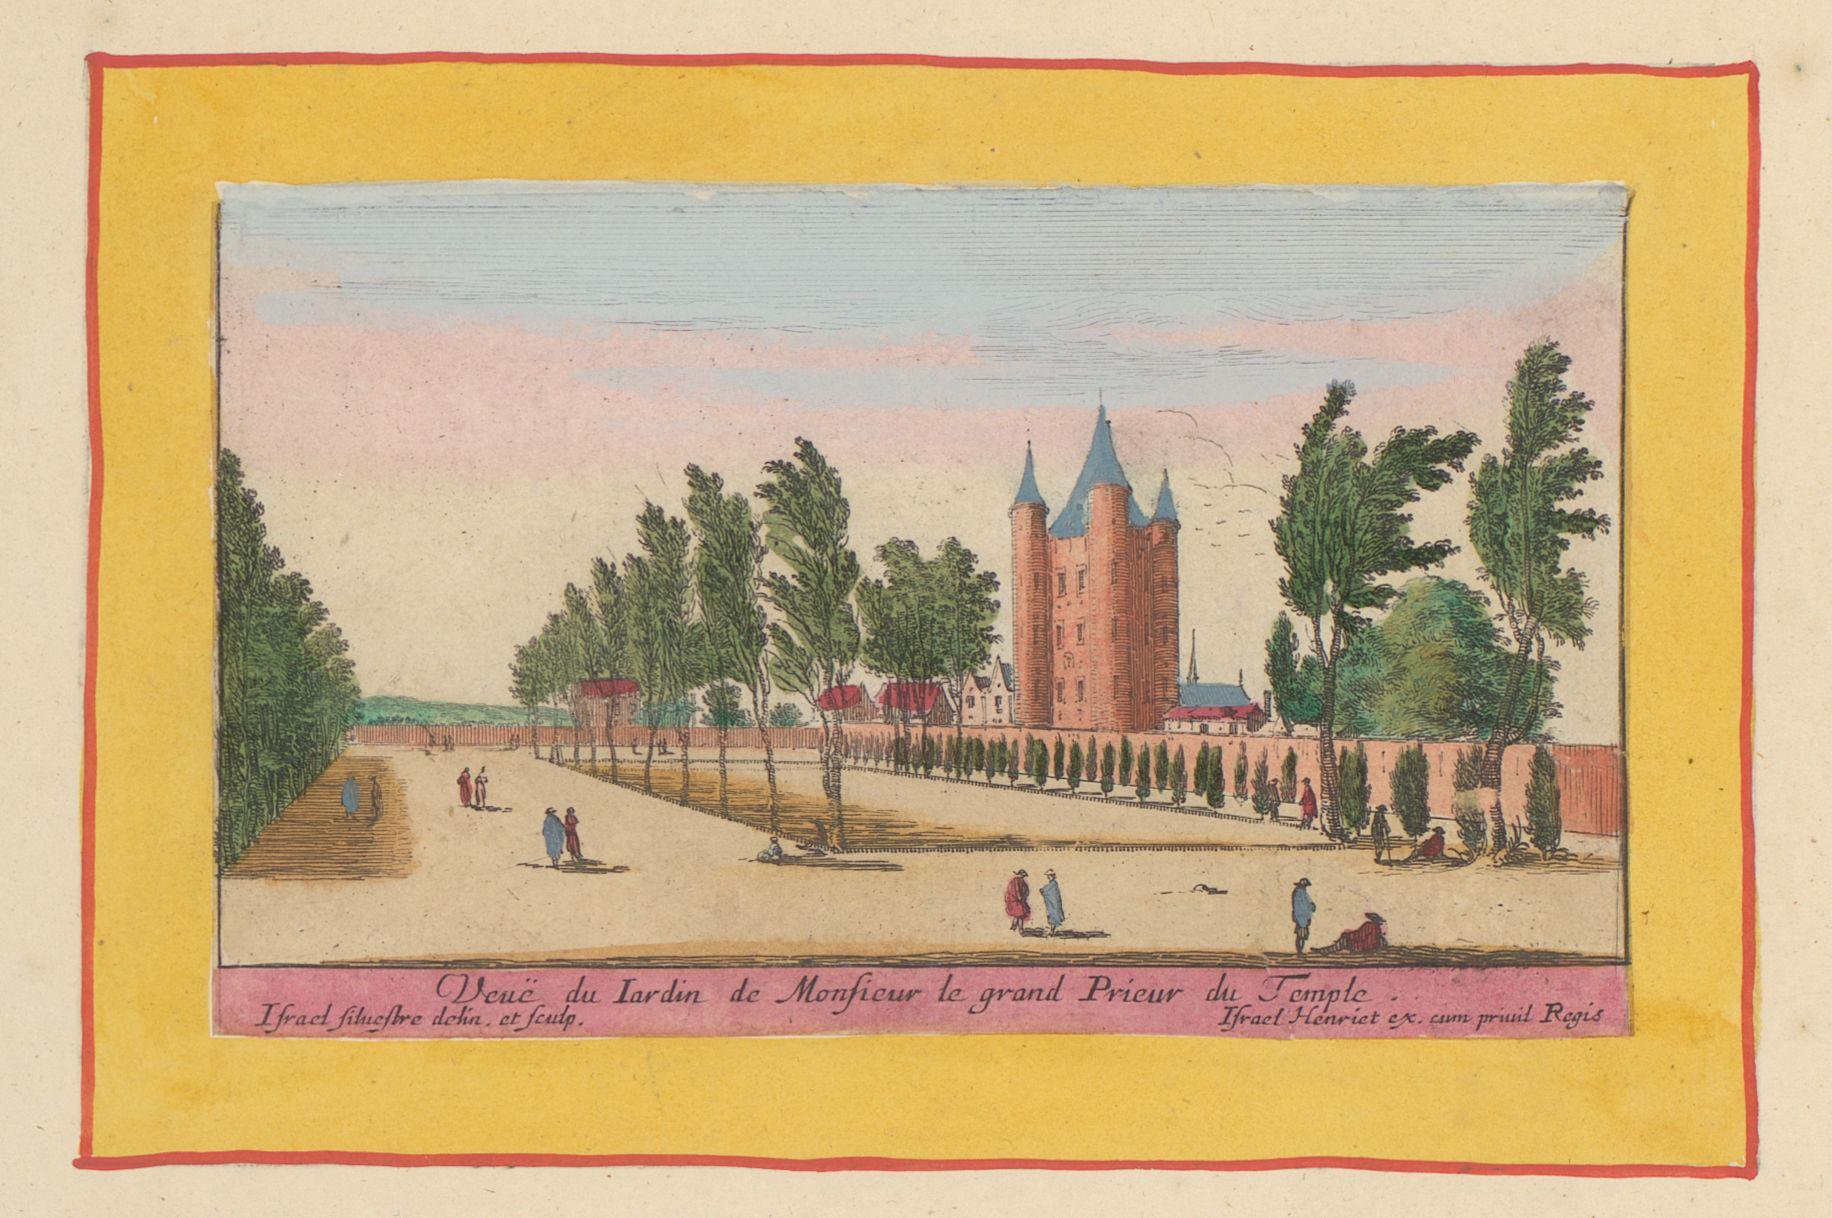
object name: print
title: Gezicht op de Tour du Temple te Parijs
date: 1631-1661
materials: paper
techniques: etching, hand coloring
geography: the hague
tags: fortress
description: Gezicht op de Tour du Temple te Parijs vanuit de tuinen van Hôtel du Grand Prieur. Prent maakt deel uit van een album.